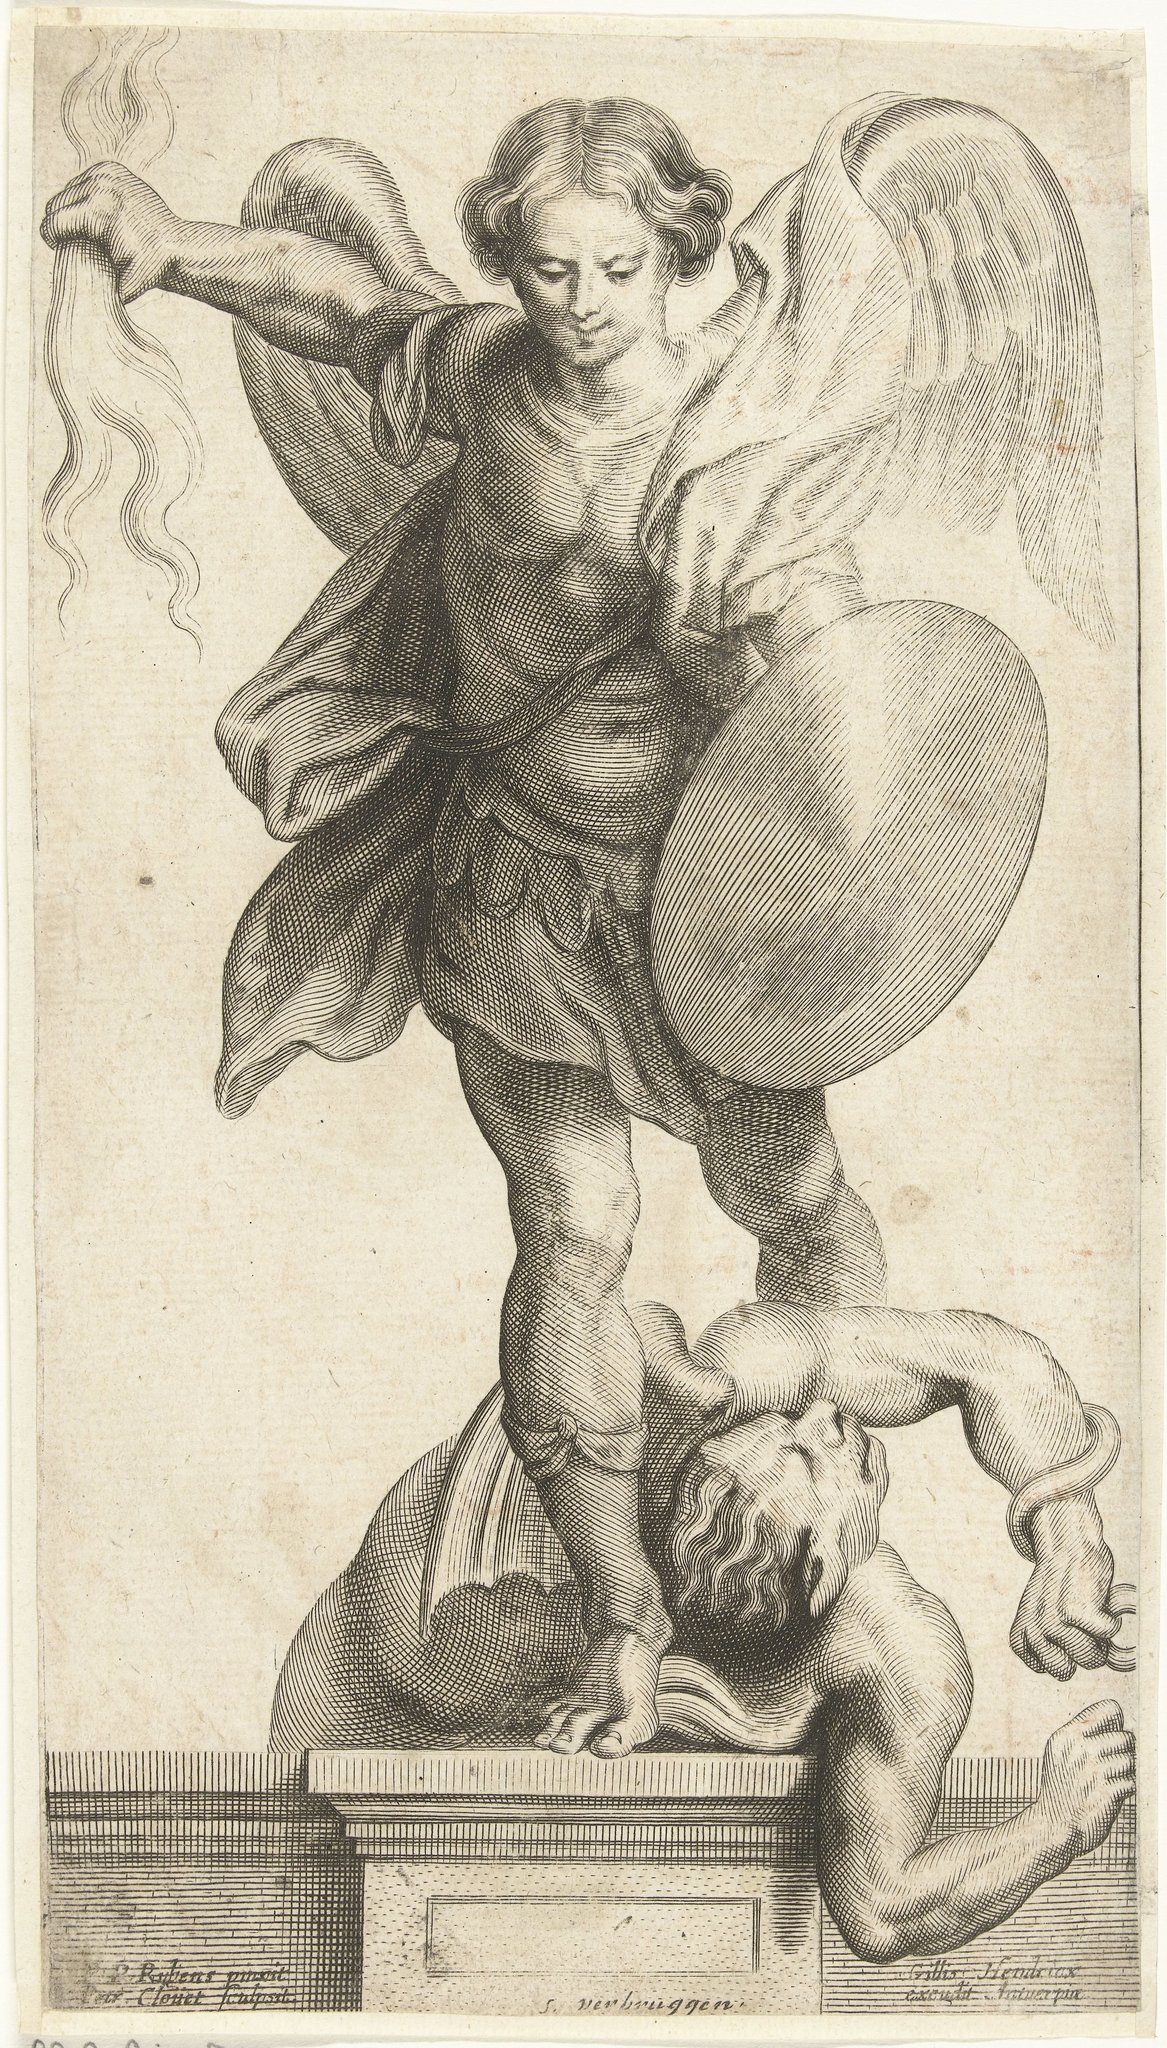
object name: print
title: Aartsengel Michaël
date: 1639-1670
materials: paper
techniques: engraving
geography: antwerp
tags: the archangel michael fighting the dragon (devil, satan)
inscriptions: collector's mark: Lugt 2228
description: De prent toont de aartsengel Michaël met een vlammenzwaard en een schild. Hij vertrappelt een duivel. De serie bestaat uit prenten gebaseerd op schilderijen van Peter Paul Rubens.